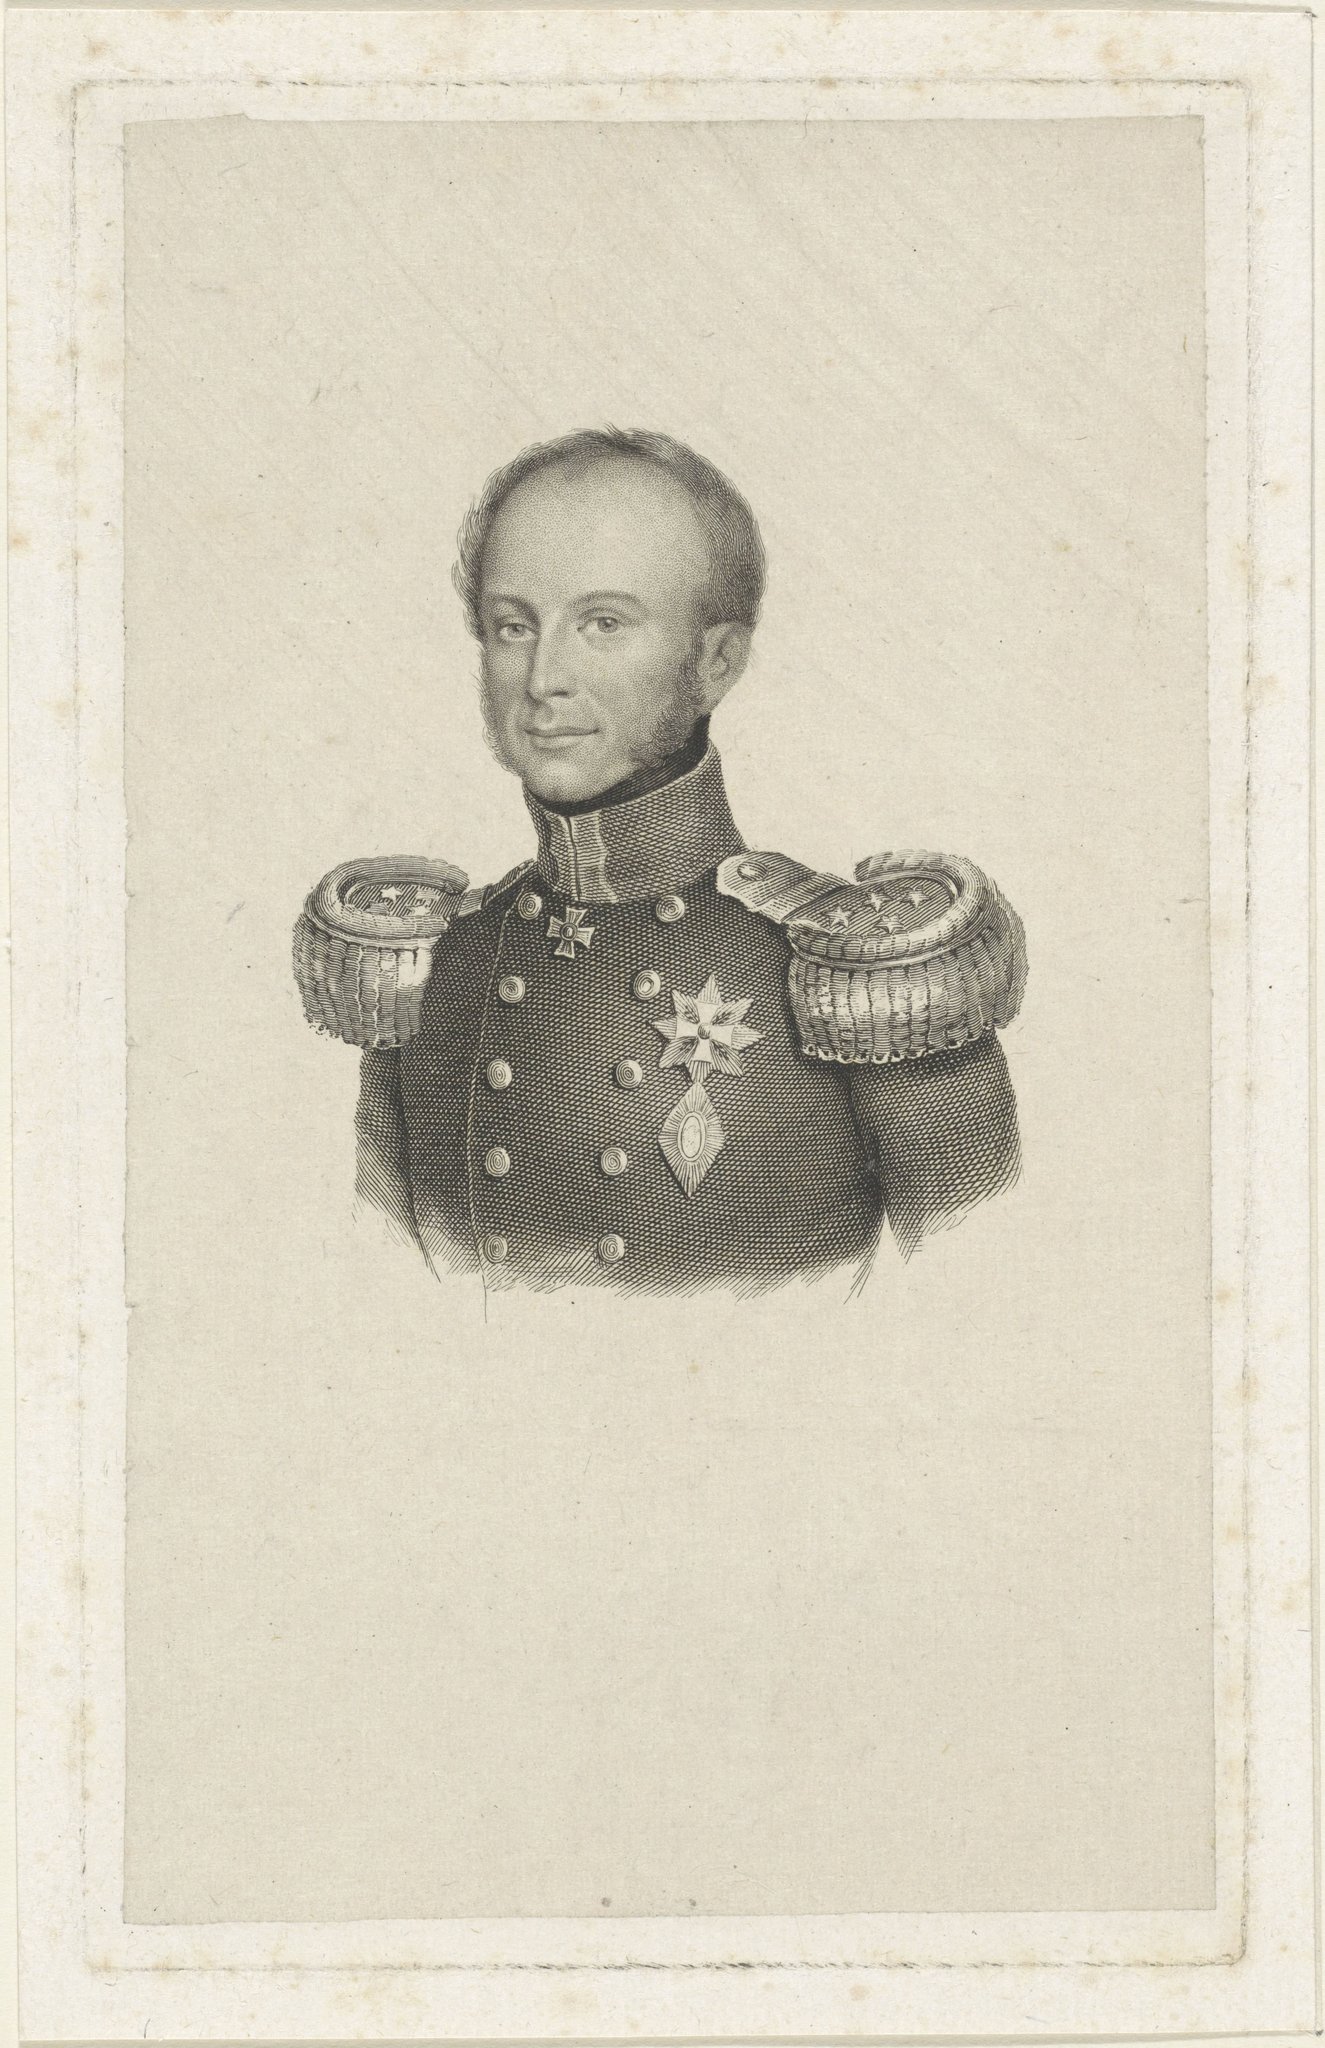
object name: print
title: Portret van Willem II, koning der Nederlanden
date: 1810-1836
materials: paper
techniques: engraving, etching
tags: the hague, william ii of the netherlands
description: De hier vermelde titel verwijst naar de hoogst verkregen titel van de geportretteerde, niet per se naar de titel die de geportretteerde op deze voorstelling draagt.